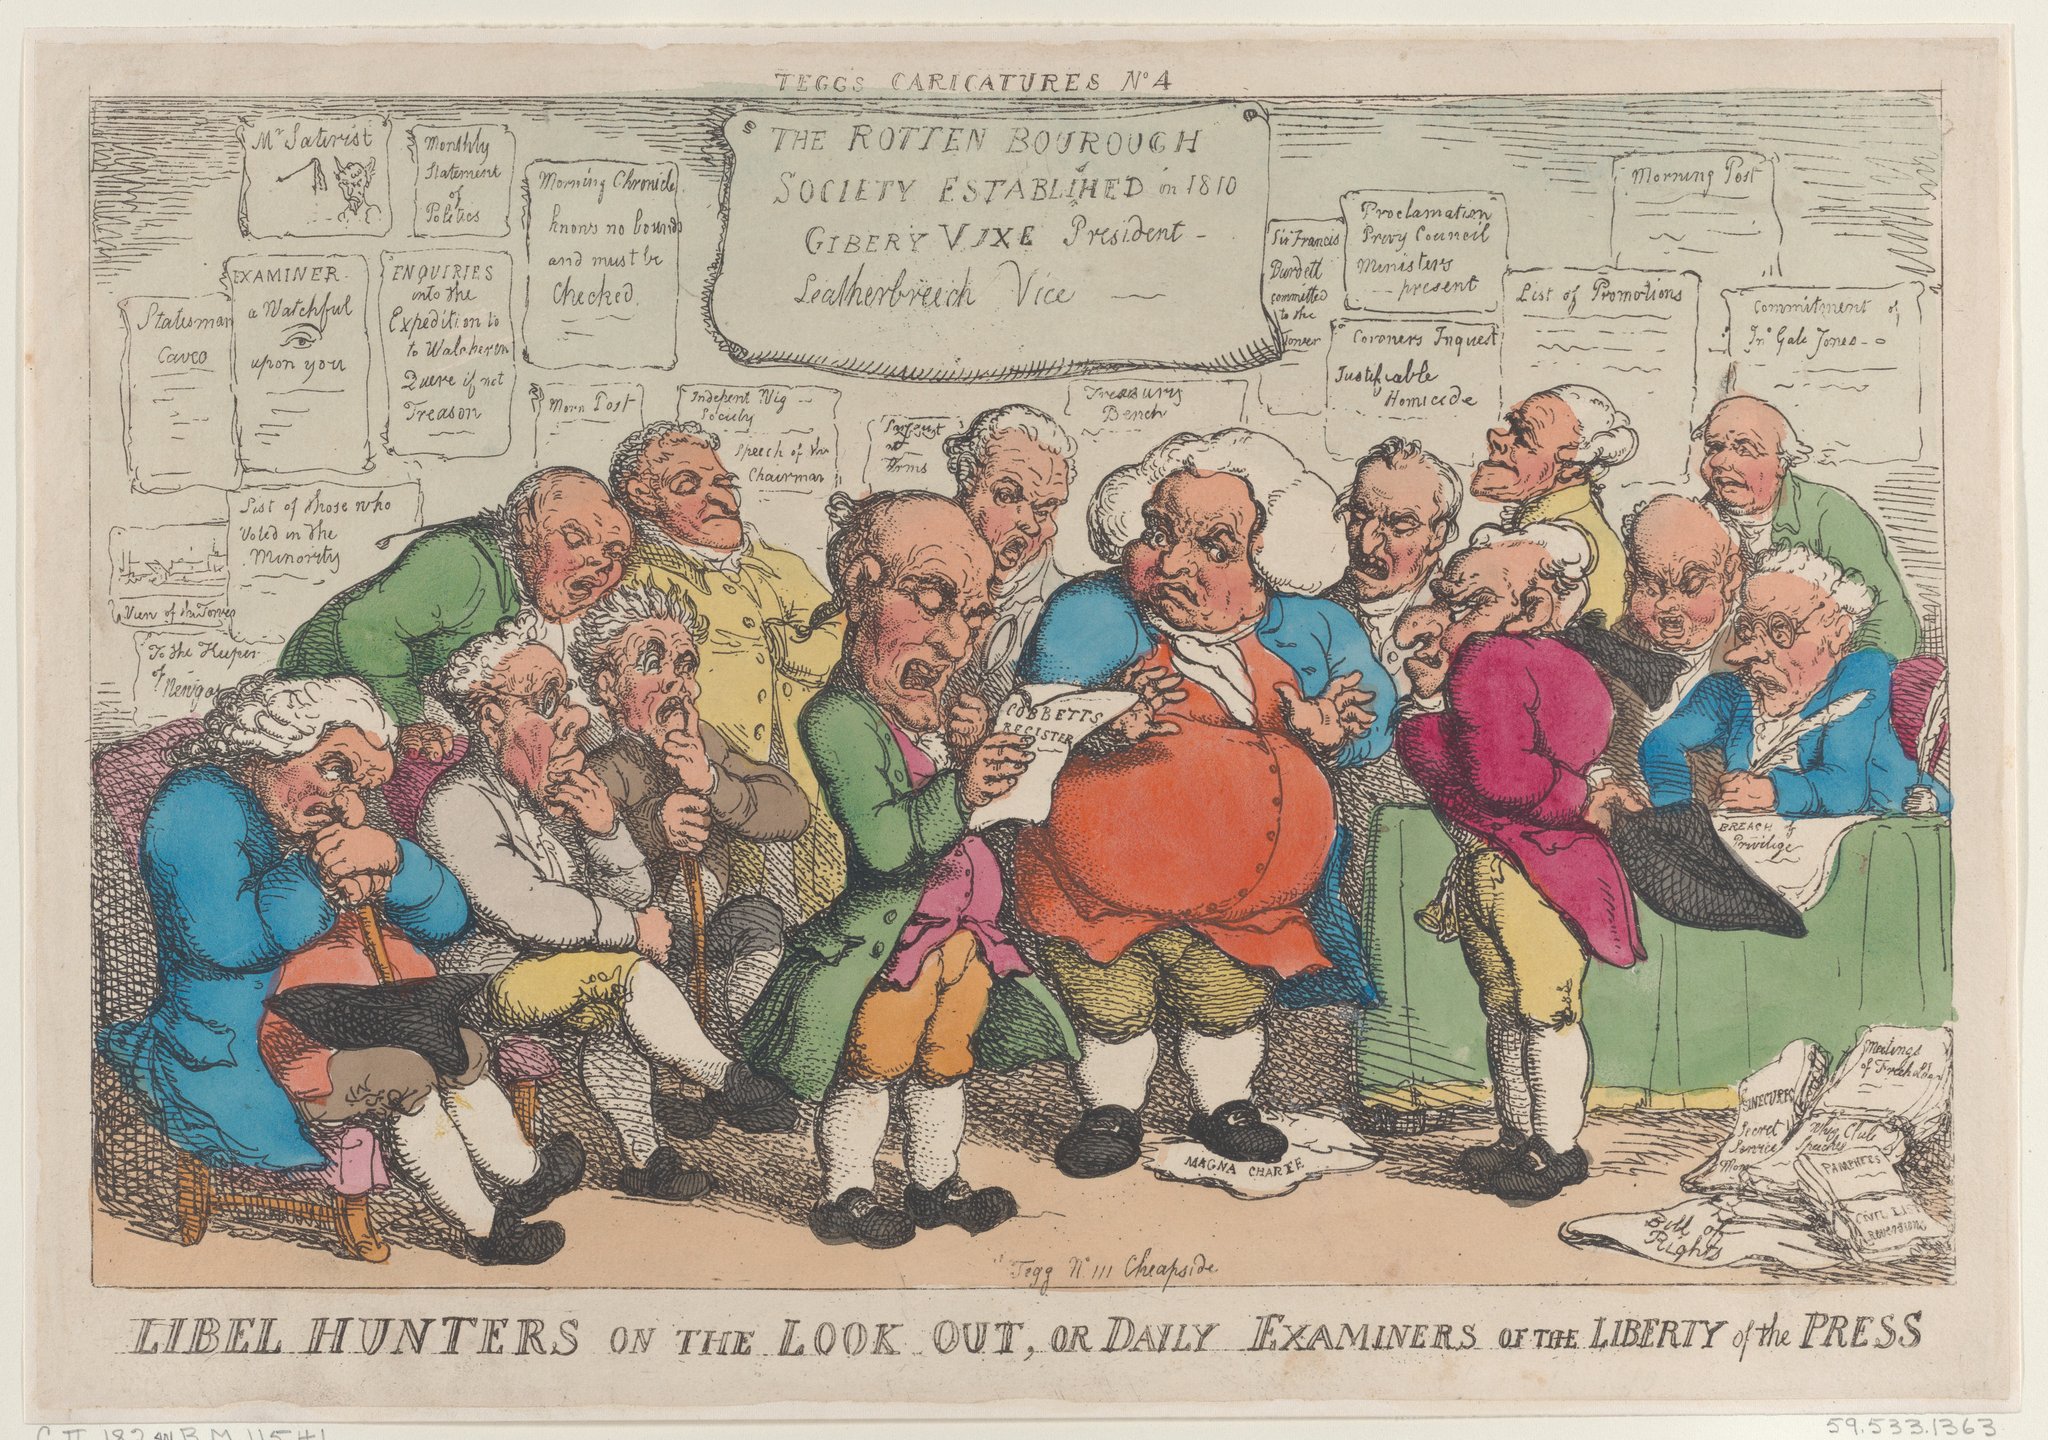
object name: print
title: Libel Hunters on the Lookout, or Daily Examiners of the Liberty Press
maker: thomas rowlandson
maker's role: artist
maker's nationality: british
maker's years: 1757-1827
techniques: etching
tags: satire,men